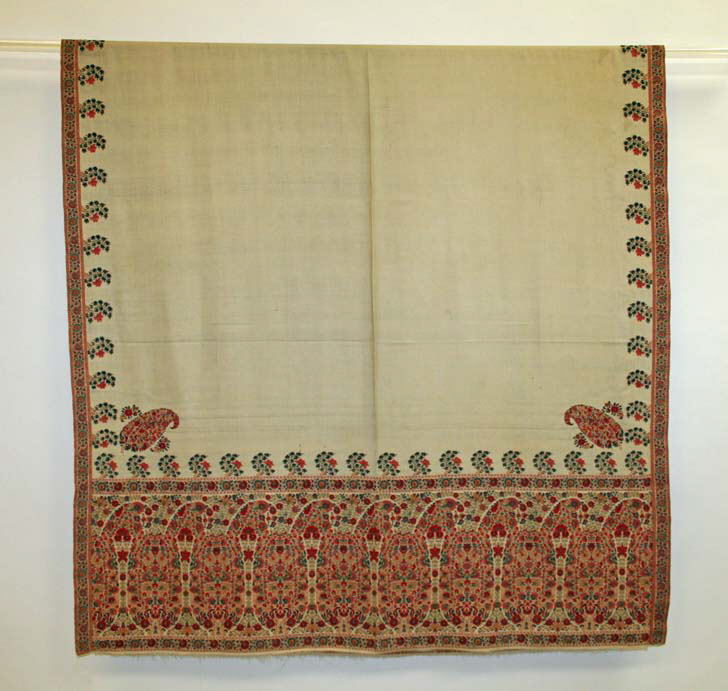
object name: shawl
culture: british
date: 1815-1820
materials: cotton, silk